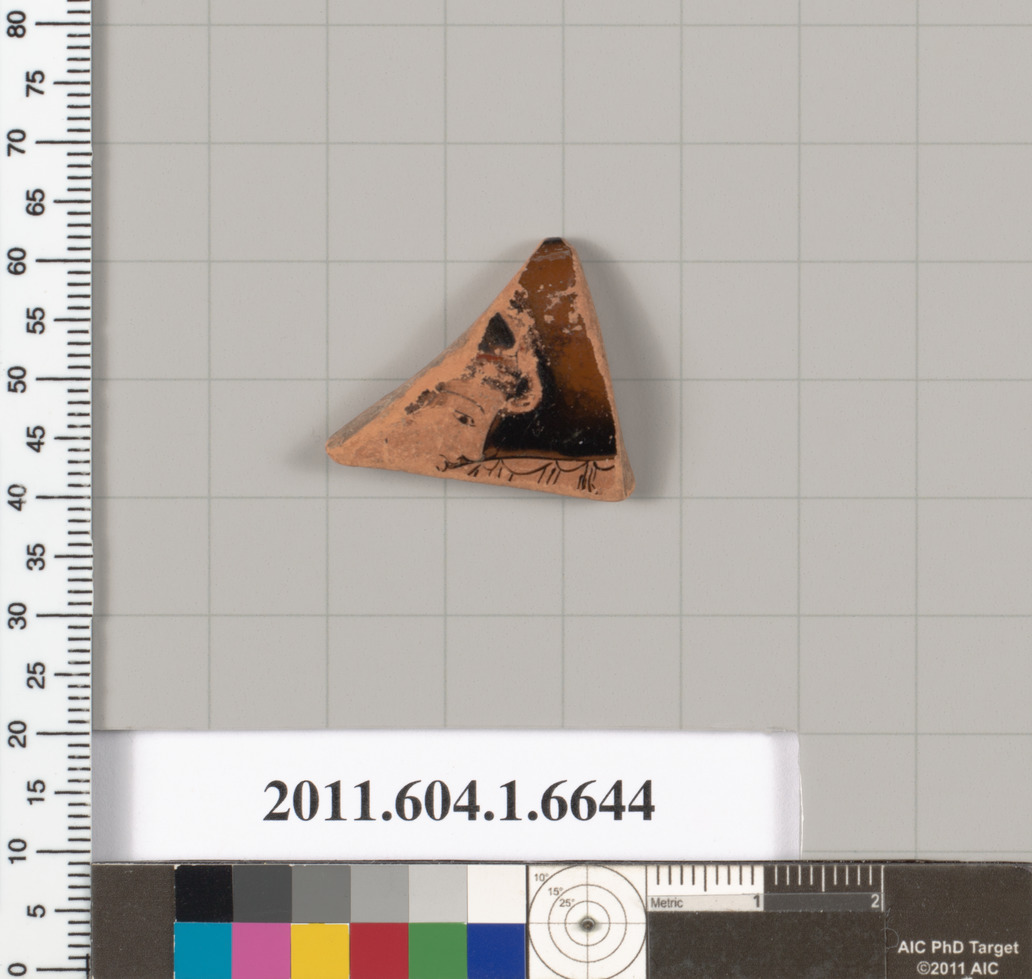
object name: kylix fragment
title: Terracotta rim fragment of a kylix (drinking cup)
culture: greek, attic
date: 490-470 BCE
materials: terracotta